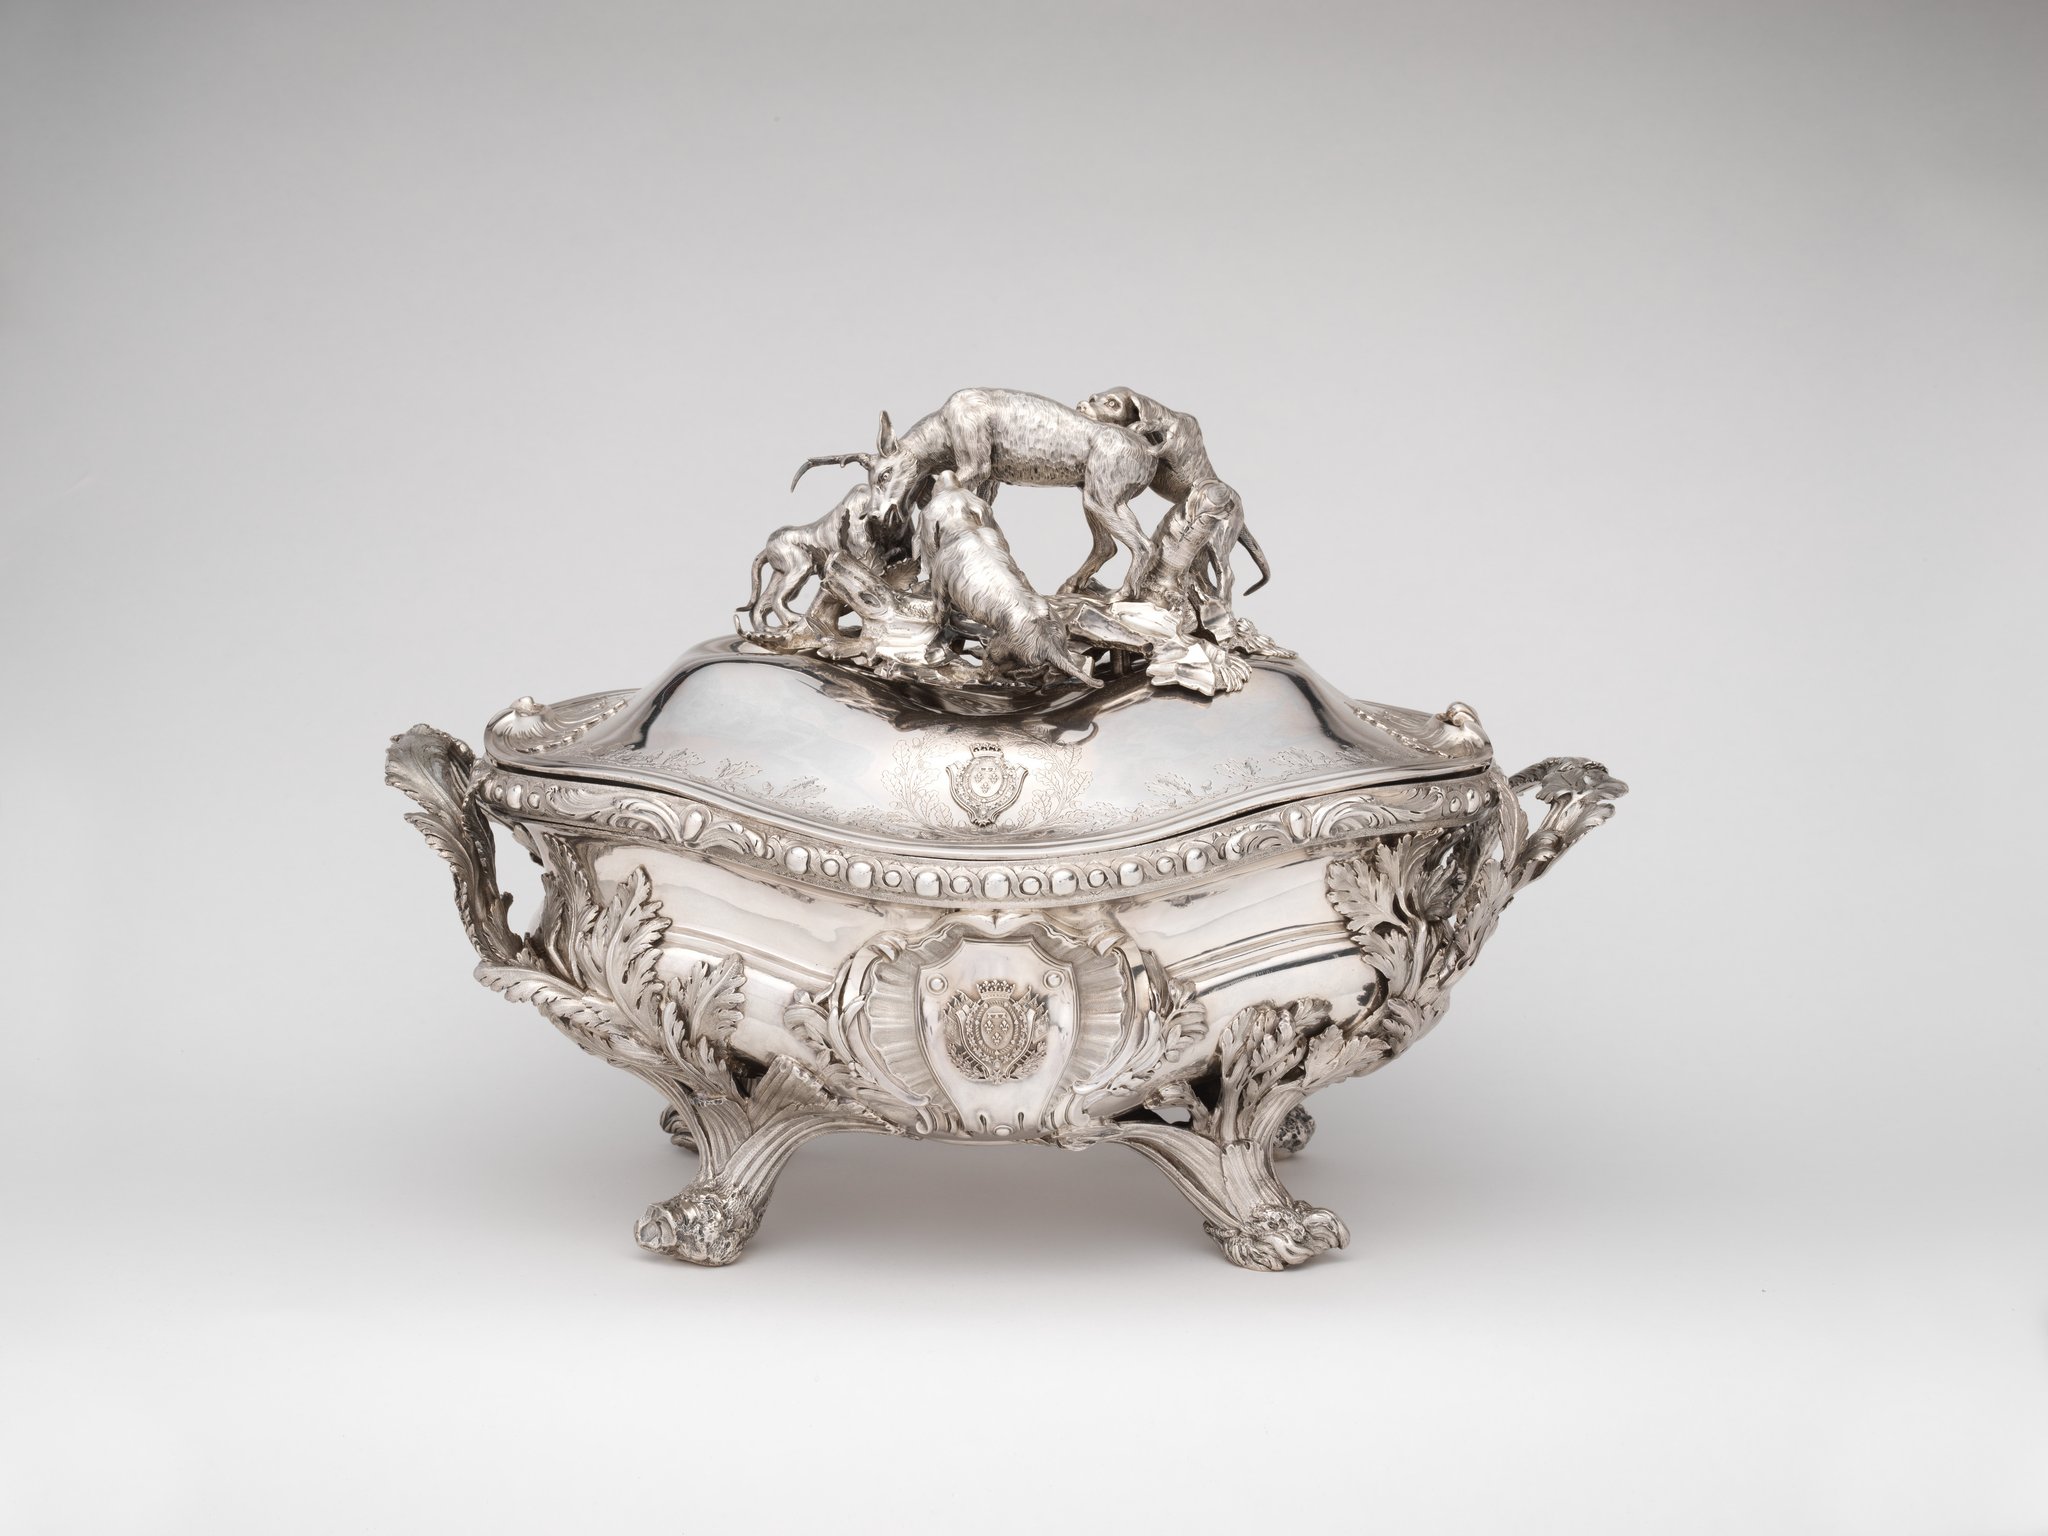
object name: tureen with cover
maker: edme-pierre balzac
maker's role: maker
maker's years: 1705-1786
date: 1757-1759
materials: silver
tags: deer,dogs,coat of arms